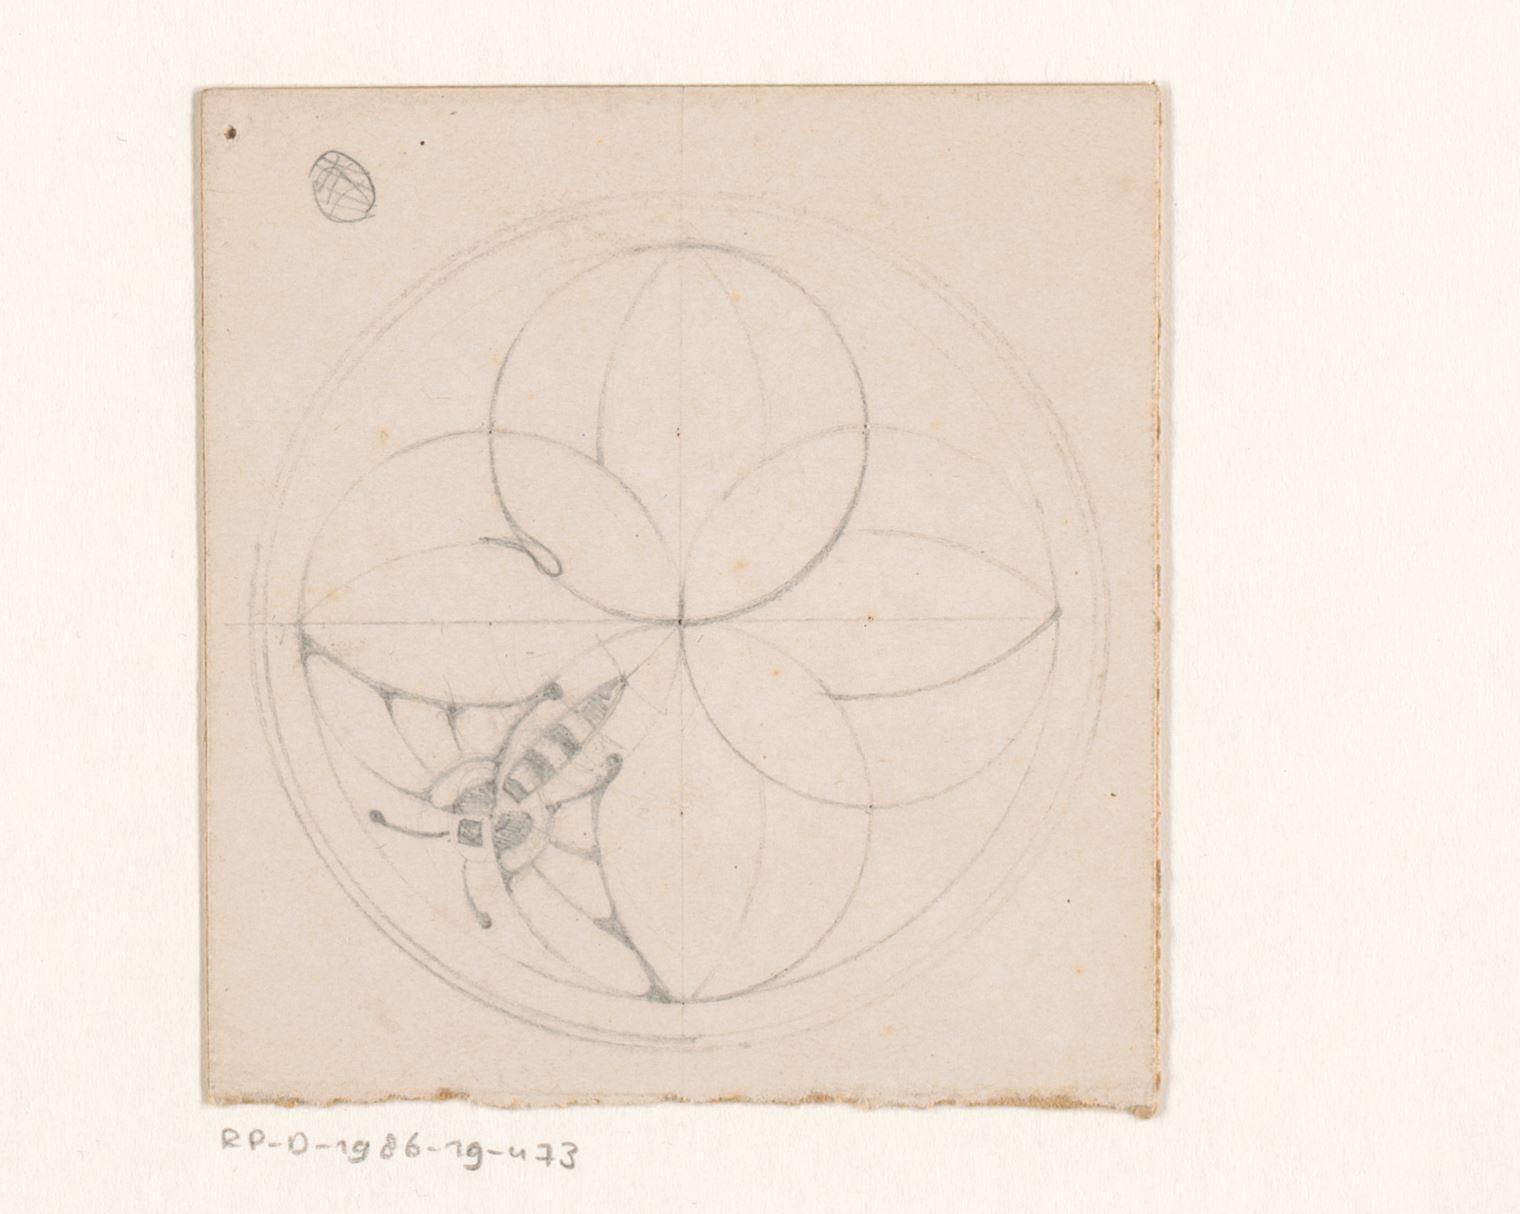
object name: drawing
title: Rond ornament met blad- en vlindermotief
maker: reinier willem petrus de vries (1874-1953)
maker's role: draughtsman, print maker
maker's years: 1874-1953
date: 1884-1952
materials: paper, pencil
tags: ornament ~ round and curved forms, insects: butterfly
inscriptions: collector's mark: ‘R:MVS.’